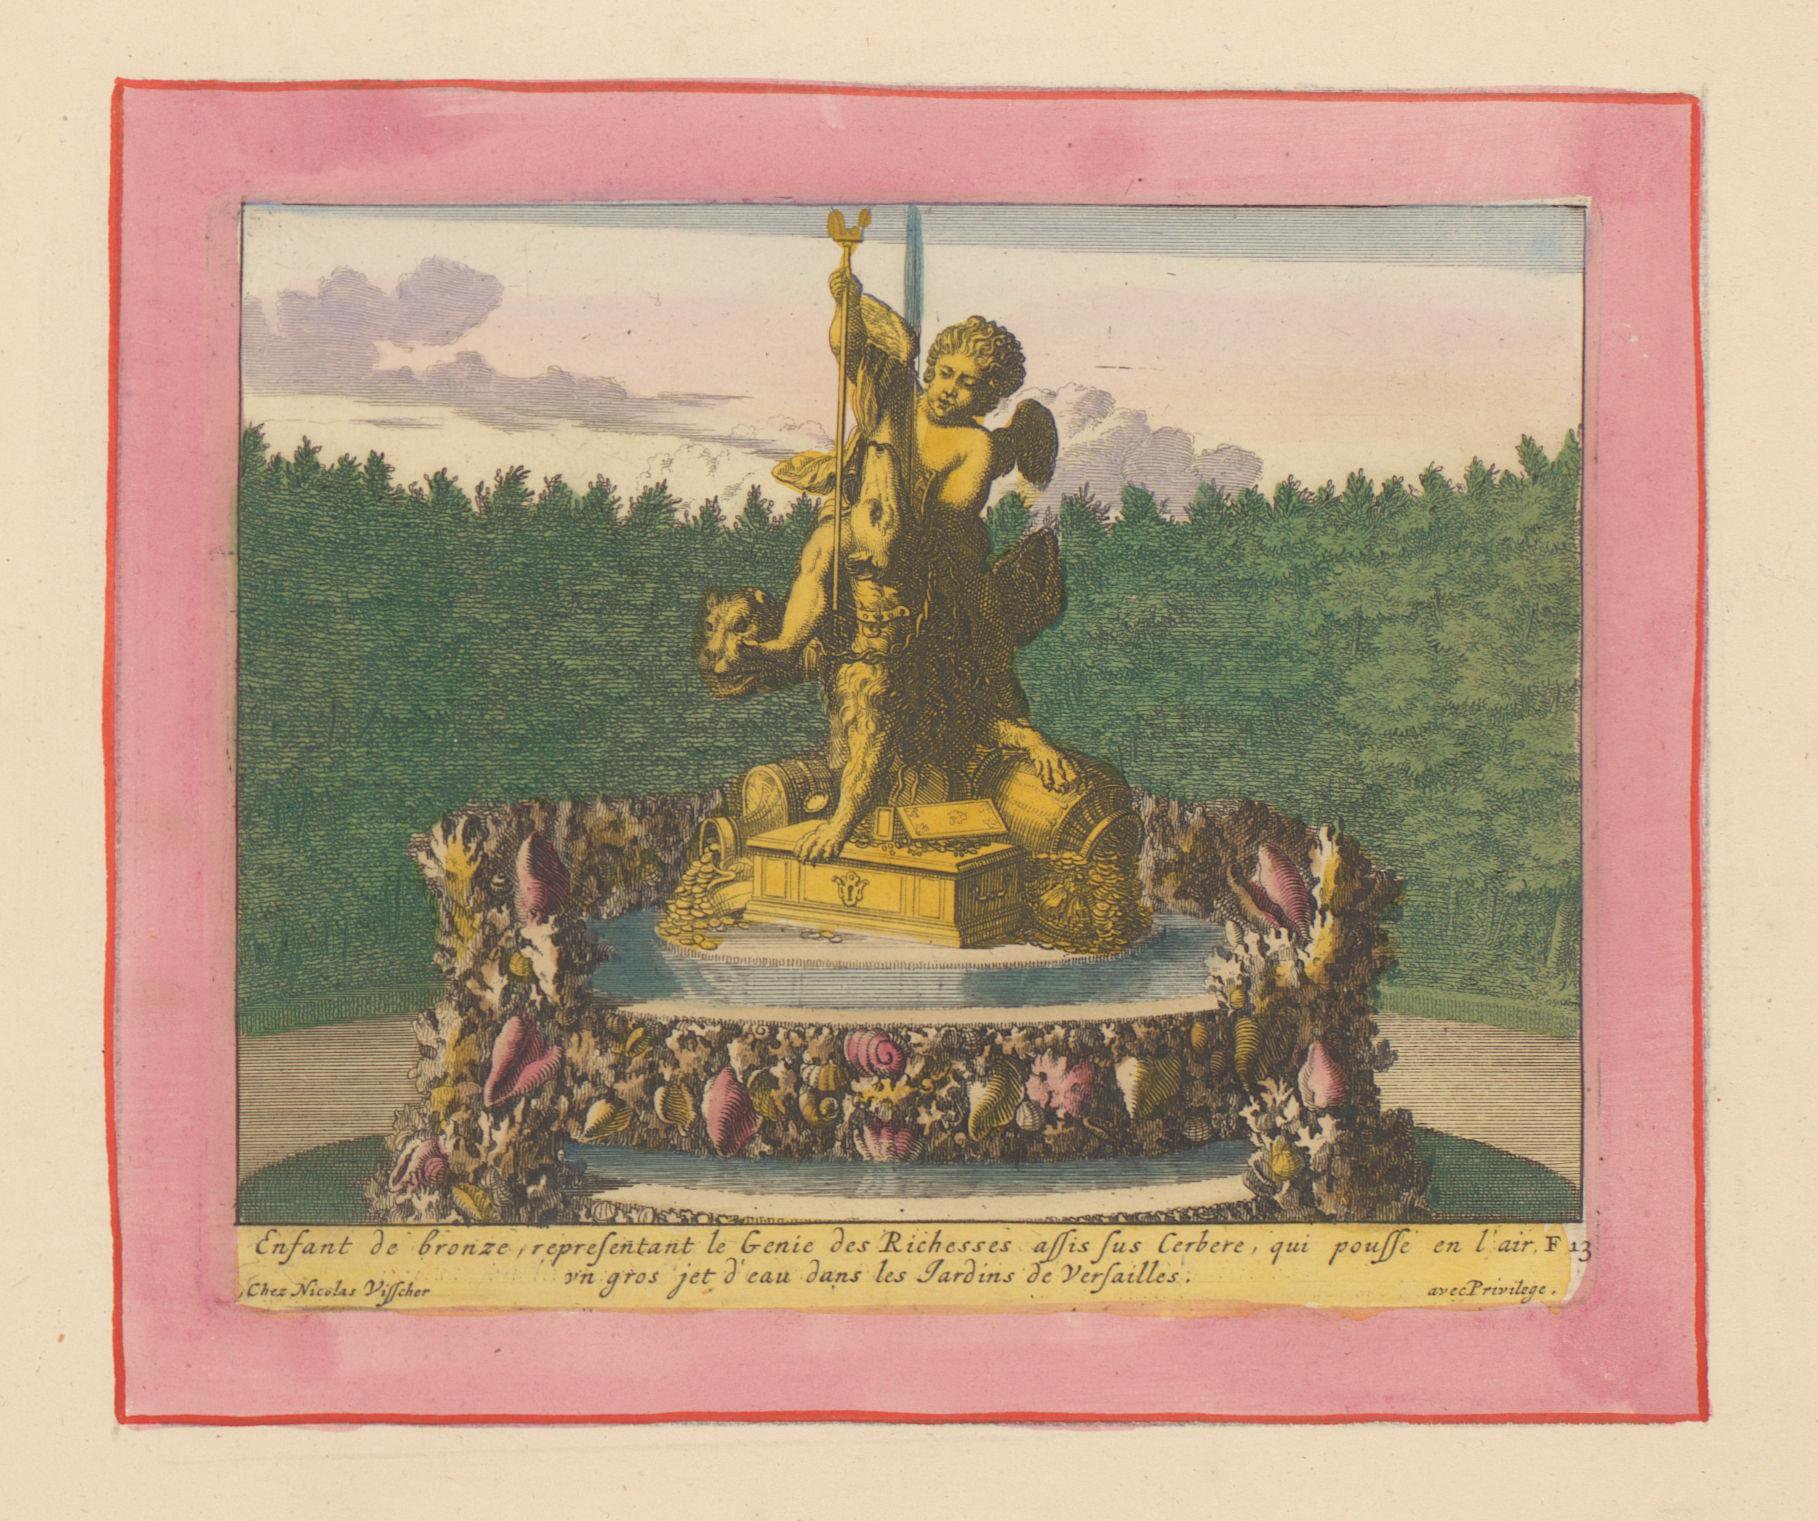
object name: print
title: Enfant de bronze, representant le Genie des Richesses affis sus Cerbere, qui pousse en l'air un gros jet d'eau dans les Jardins de Versailles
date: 1686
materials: paper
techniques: etching, hand coloring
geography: the hague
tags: garden fountain, cerberus, the three- or many-headed dog; 'cerbero' (ripa), statues, sculptures in garden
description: Fontein met een putto als personificatie van rijkdom gezeten op Cerberus in de tuinen van Versailles. Rechtsonder het serienummer: F13. Prent maakt deel uit van een album.